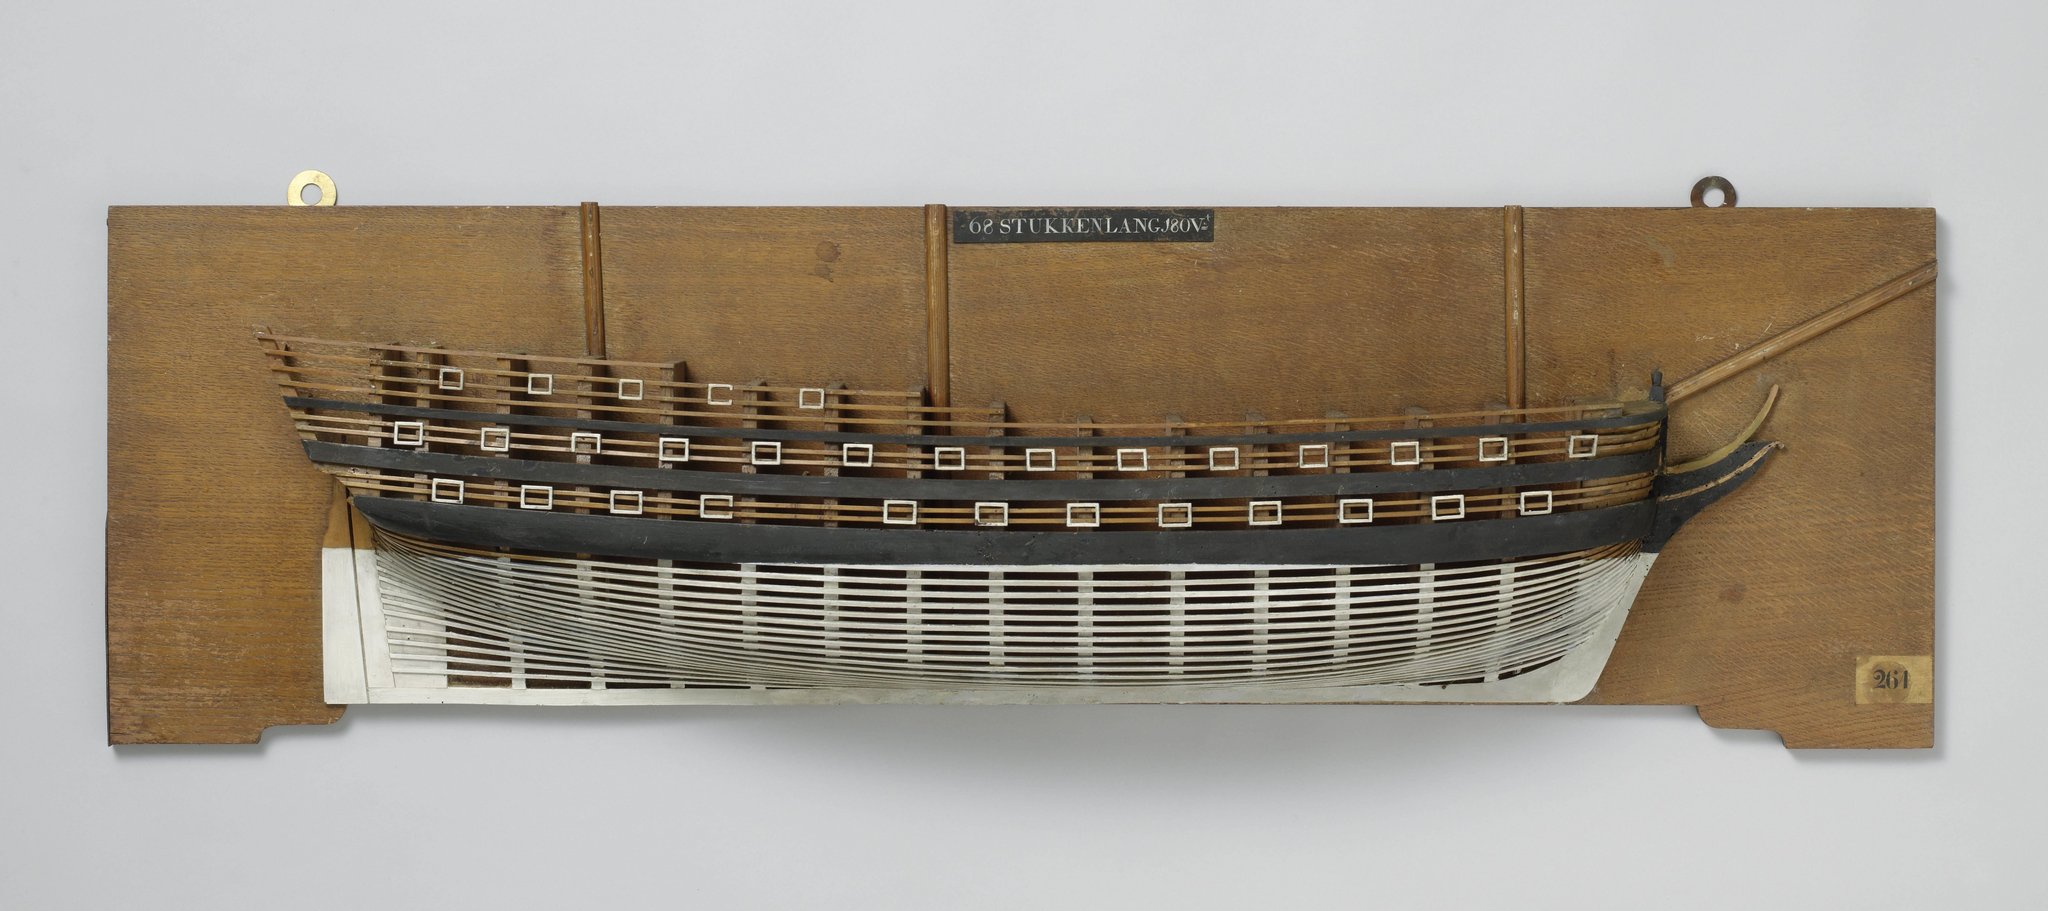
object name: ship model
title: Half Model of a 68-Gun Ship of the Line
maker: Anonymous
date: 1750-1810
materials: wood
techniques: polychromy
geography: netherlands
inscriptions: inscription, top centre, on a square black metal label: ‘68 STUKKEN LANG 180 Vt’, label, bottom right: ‘261’ former inventory label